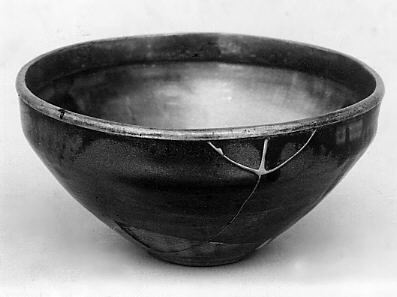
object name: teabowl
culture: japanese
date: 1801-1900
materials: clay, glaze, metal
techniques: overglaze